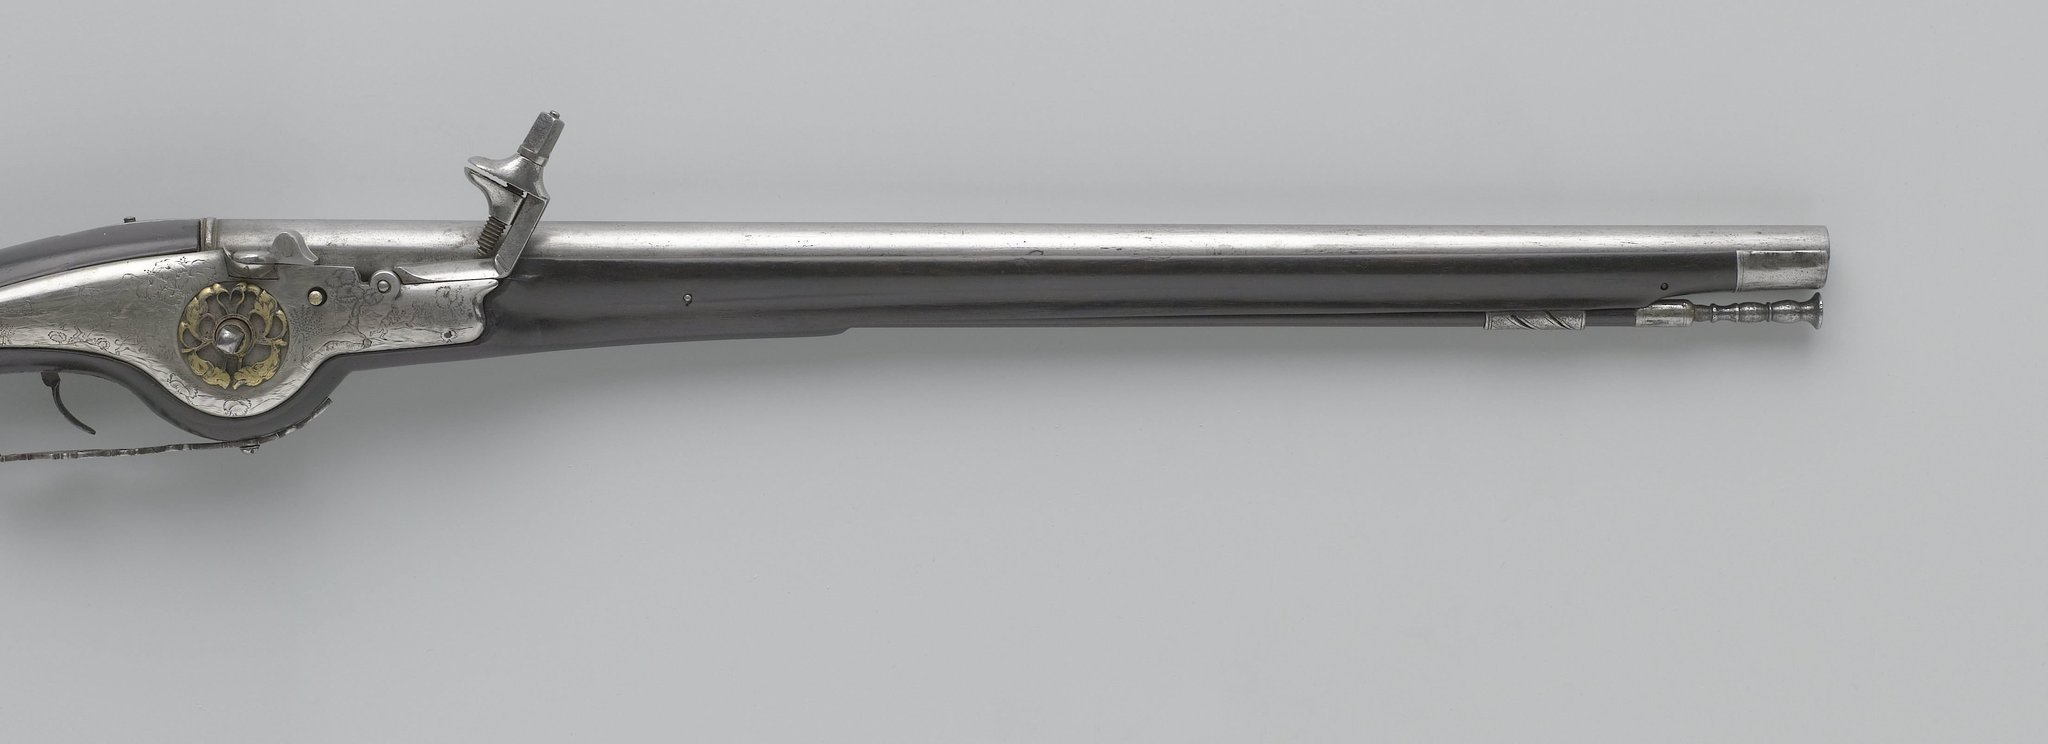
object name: radslotpistool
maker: Anonymous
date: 1650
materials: wood, iron, ivory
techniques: cutting, embroidery, engraving, gilding, relief, sawing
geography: maastricht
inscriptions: mark: ‘CMAL’